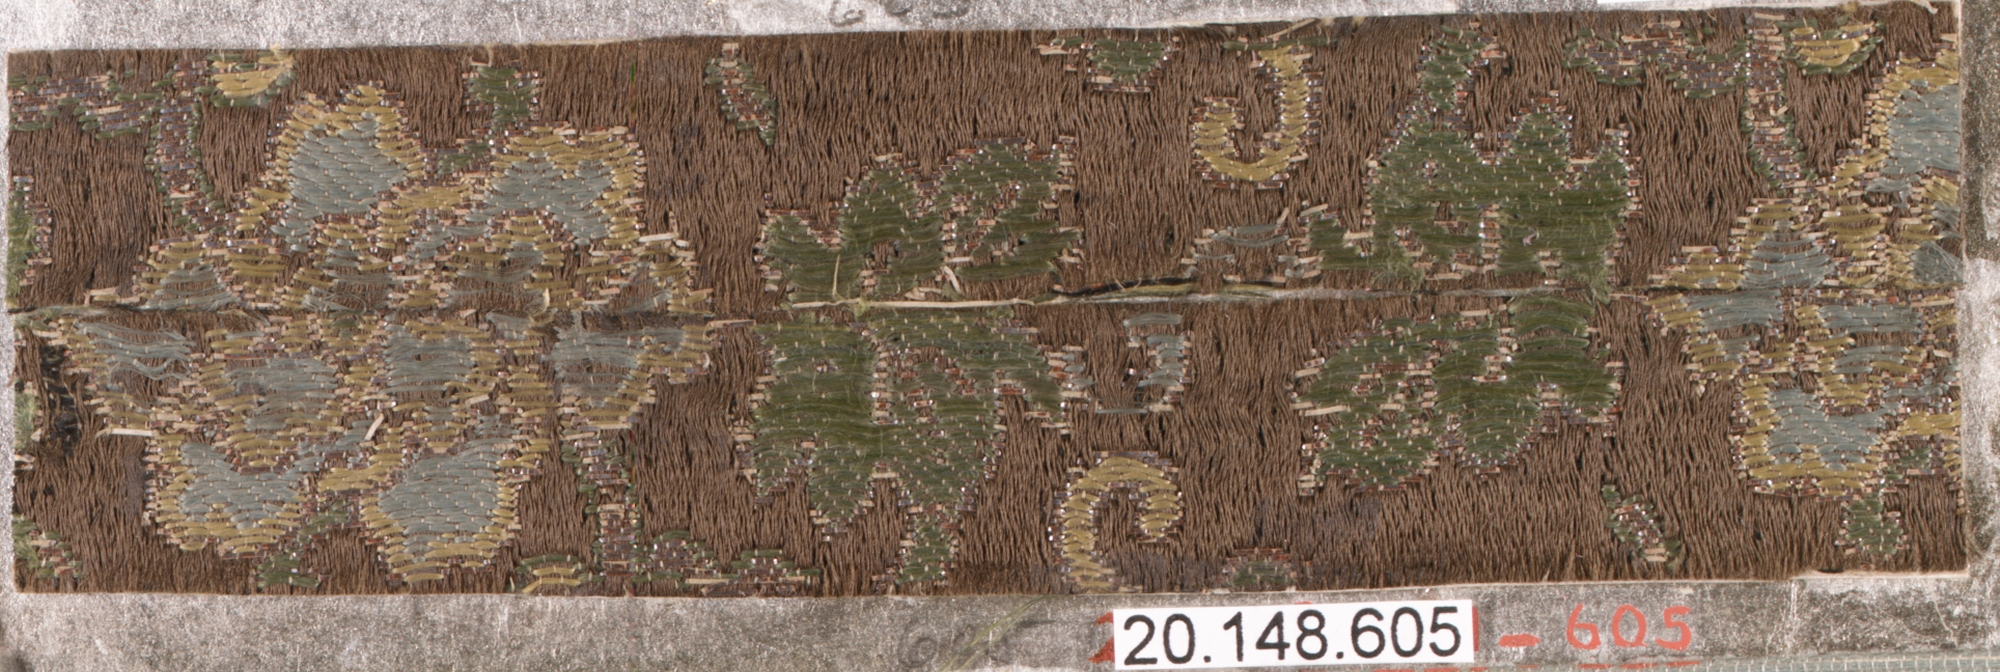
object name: piece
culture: japanese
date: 1601-1700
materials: silk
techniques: compound weave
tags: flowers,leaves